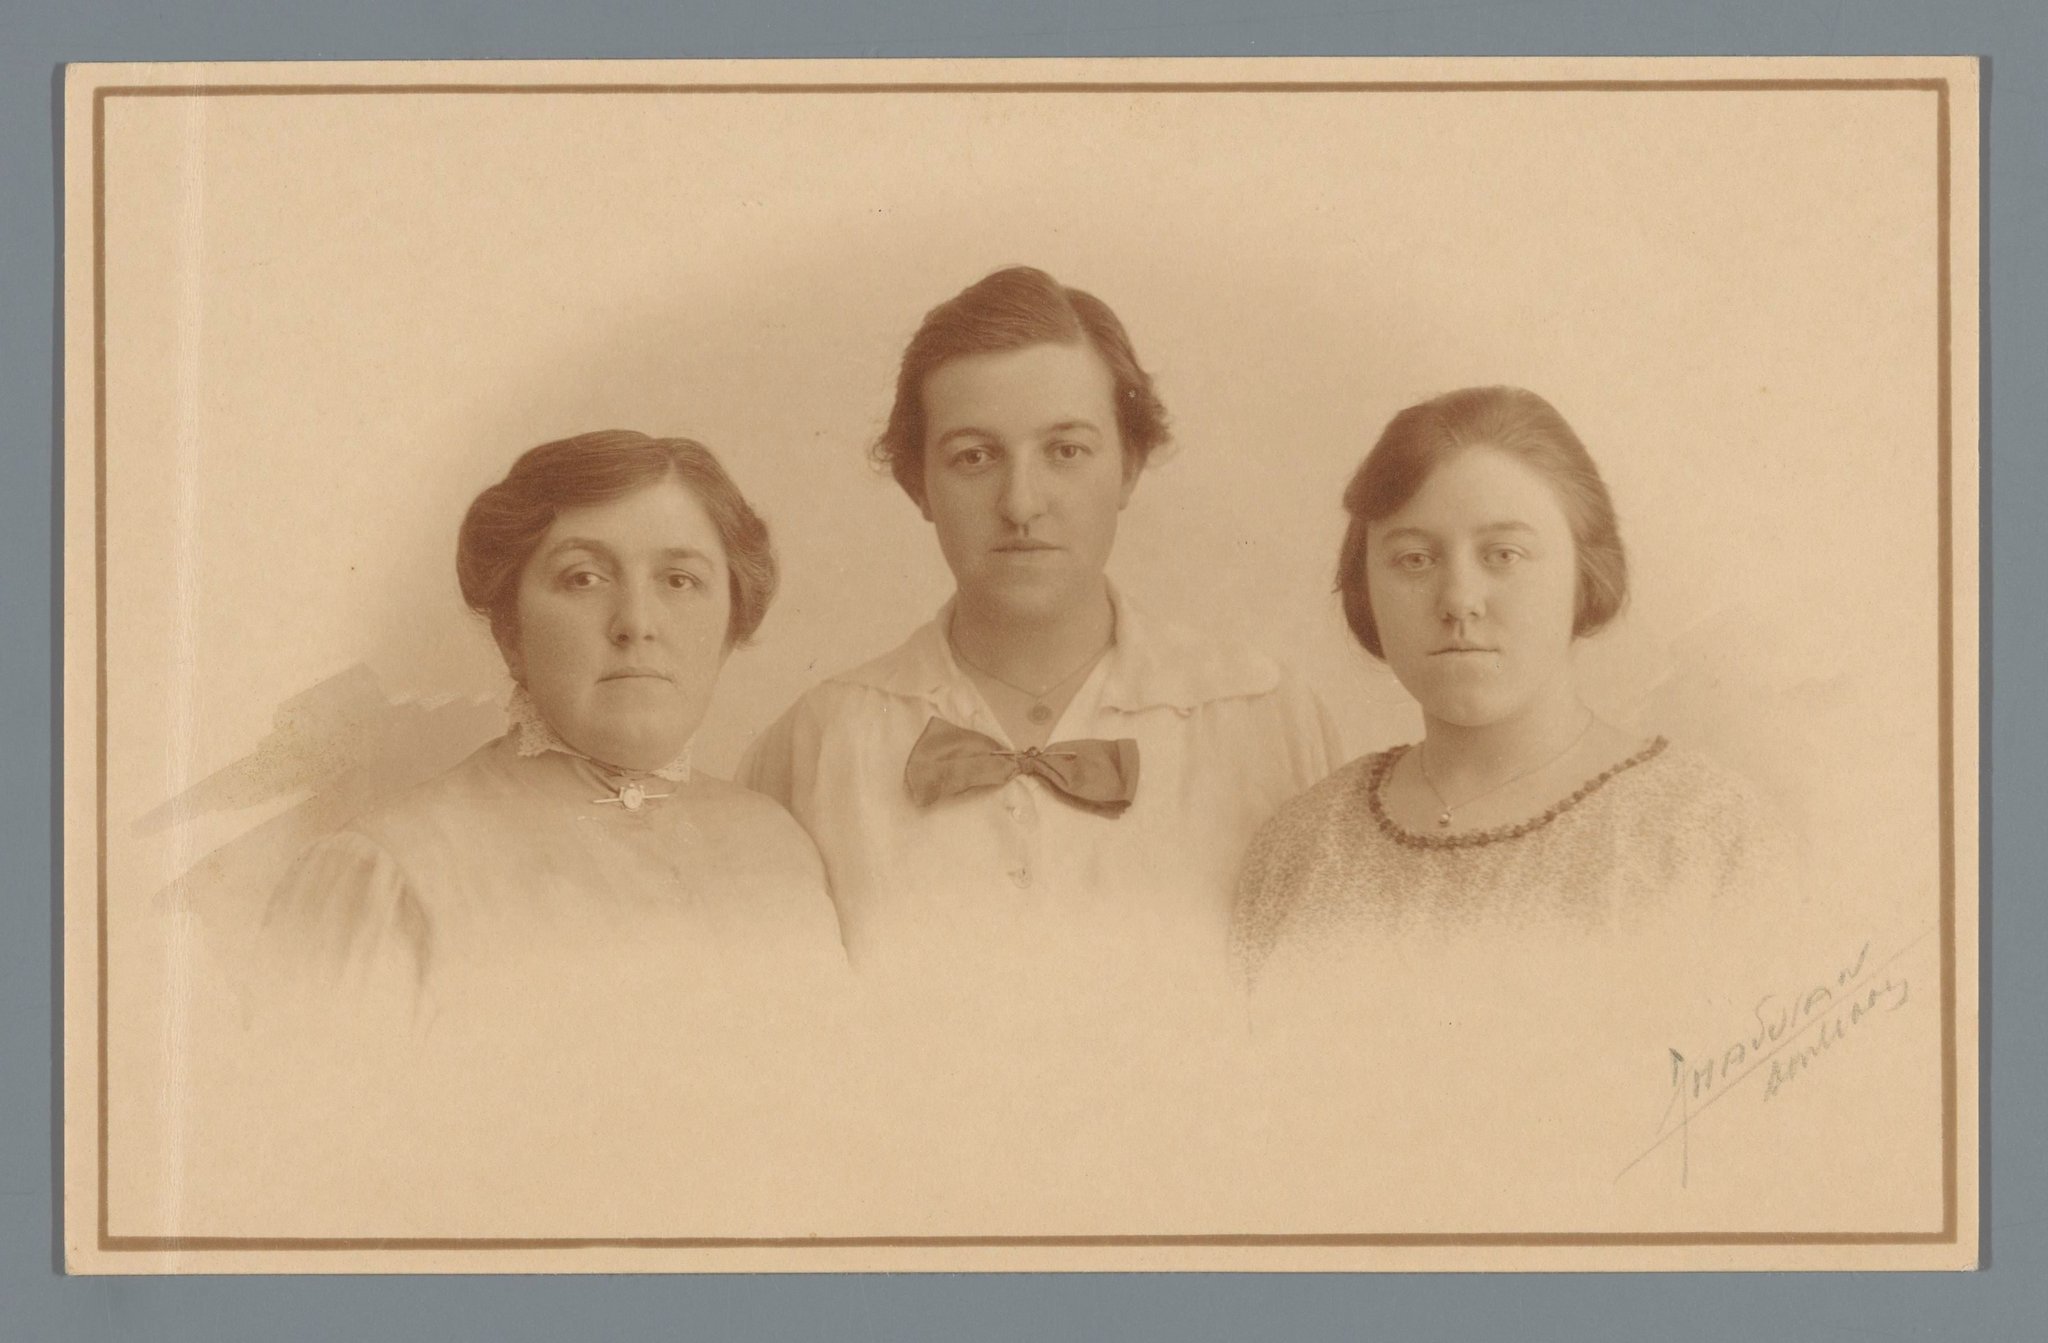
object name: ansichtkaart, prentbriefkaart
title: Portret van drie onbekende vrouwen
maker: j. maduran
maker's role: fotograaf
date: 1895-1905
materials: photographic support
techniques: gelatin silver print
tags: adult woman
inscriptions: inscription: ‘J Maduran [...]’